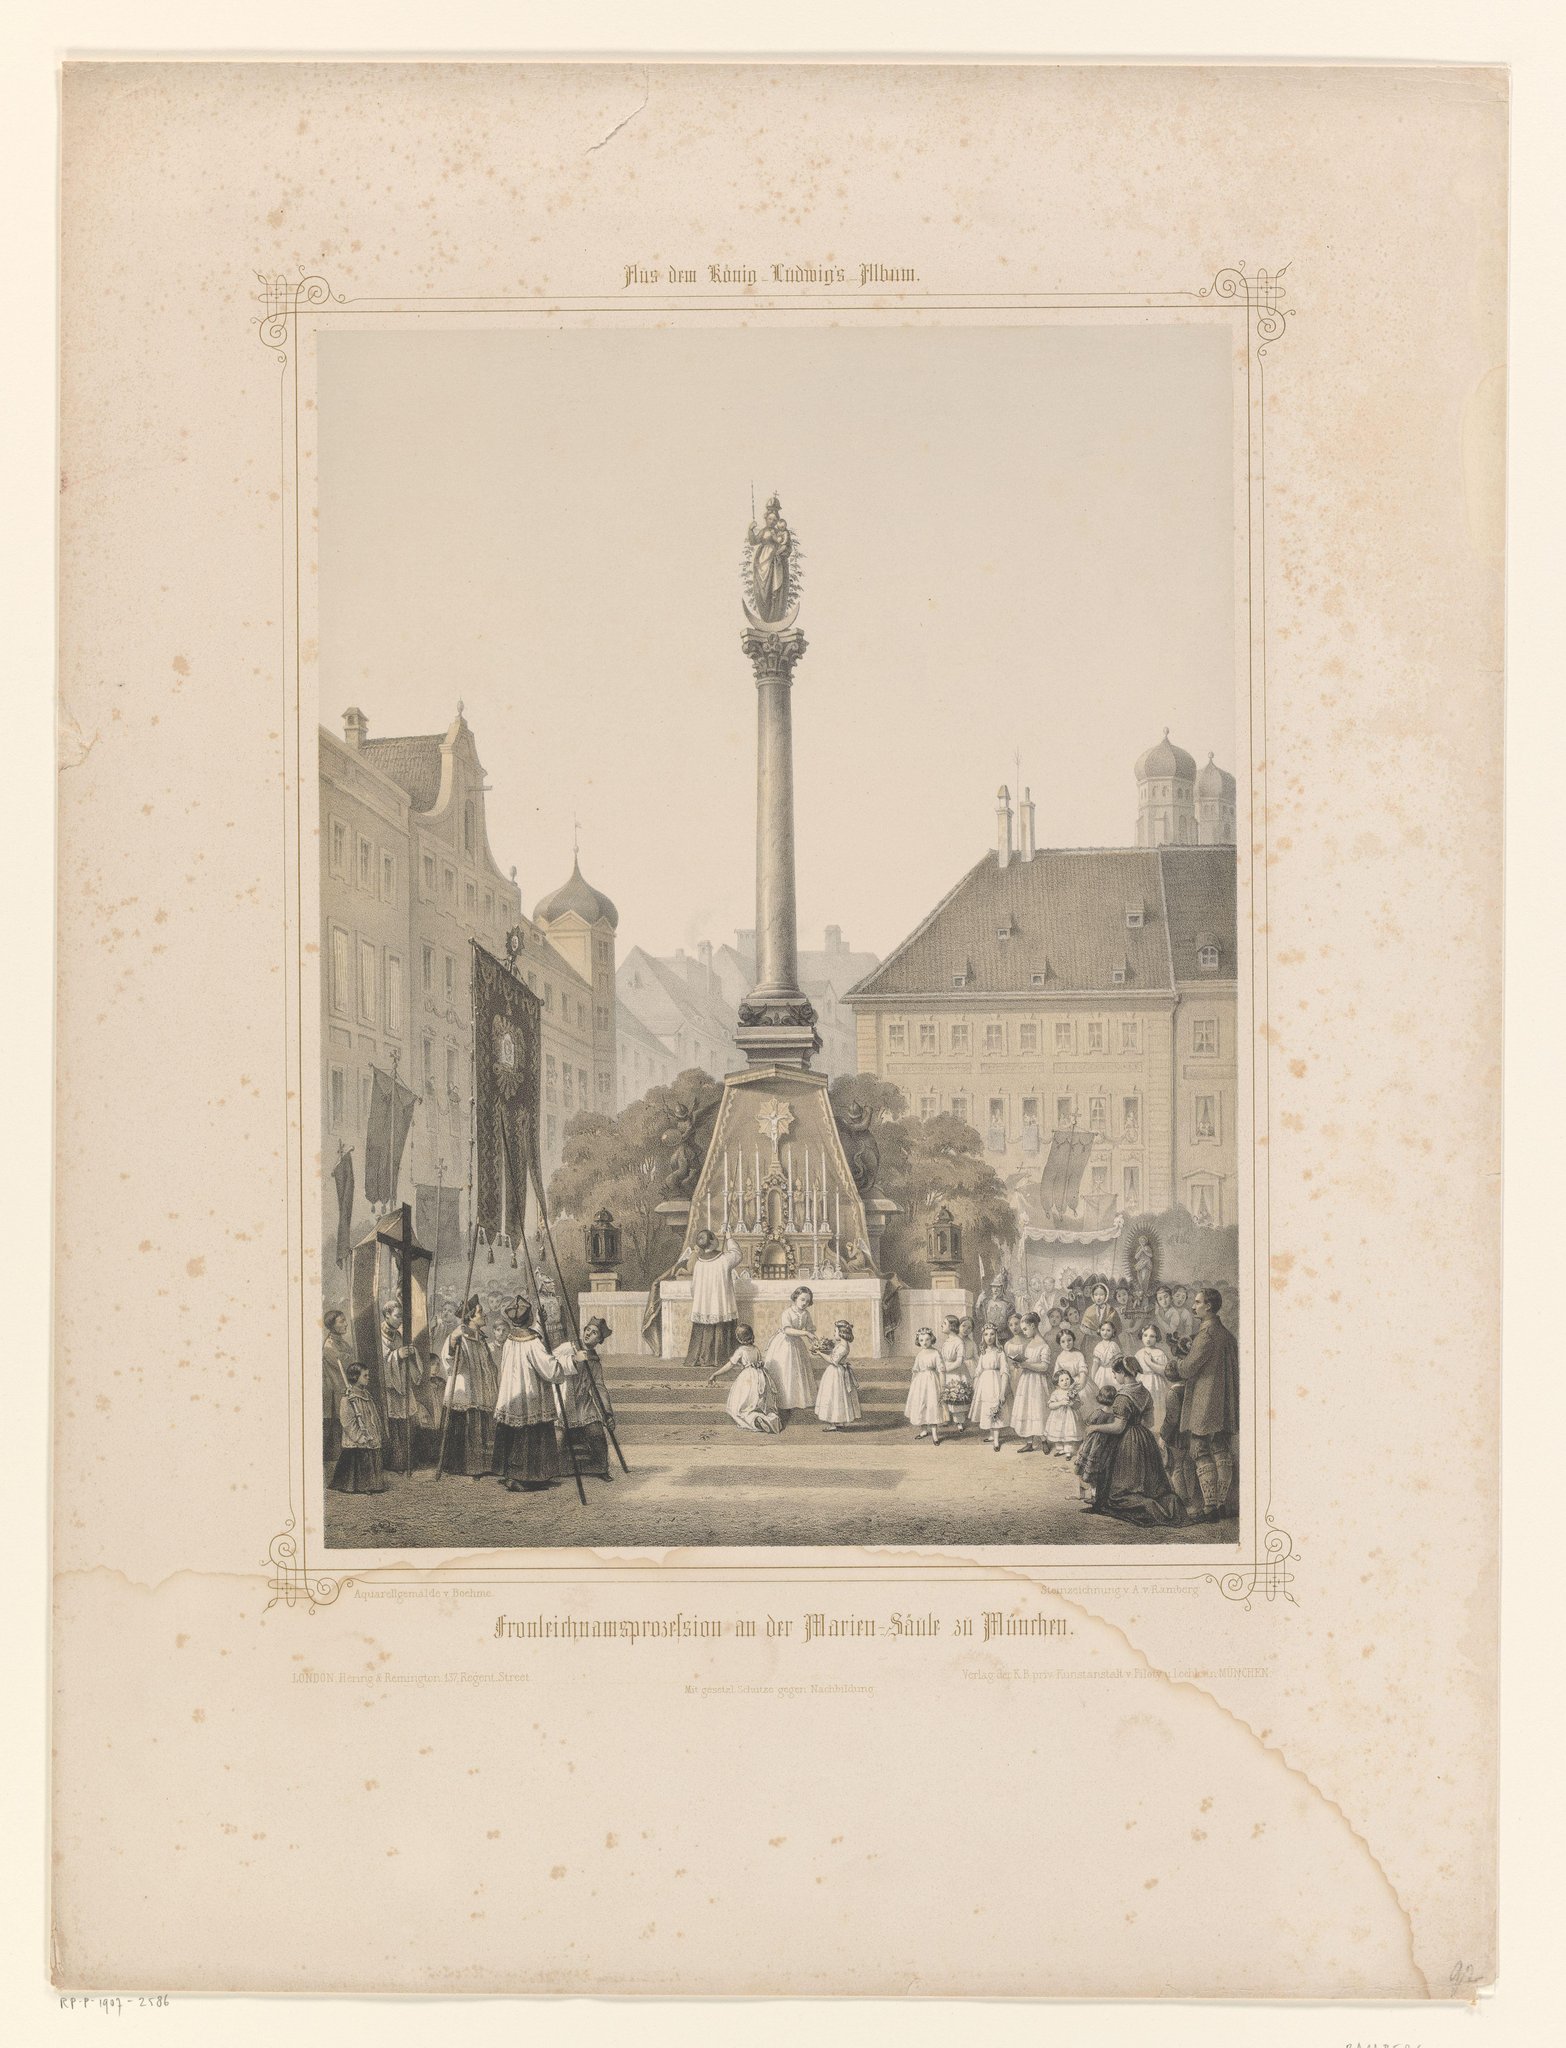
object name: print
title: Corpus Christi-processie bij de Mariazuil in München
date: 1850-1859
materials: paper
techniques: tone lithography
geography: munich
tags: monument, statue, procession ~ christian religion, village square, place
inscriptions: collector's mark: Lugt 2228, : ‘Mit gesetzl Schutze gegen Nachbildung’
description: Prent afkomstig uit de serie 'Album Seiner Majestät des Königs Ludwig I. von Bayern', verschenen in verschillende afleveringen. De prenten gaan terug op het album dat Lodewijk I van Beieren op 9 oktober 1850 kreeg overhandigd van verschillende kunstenaars.